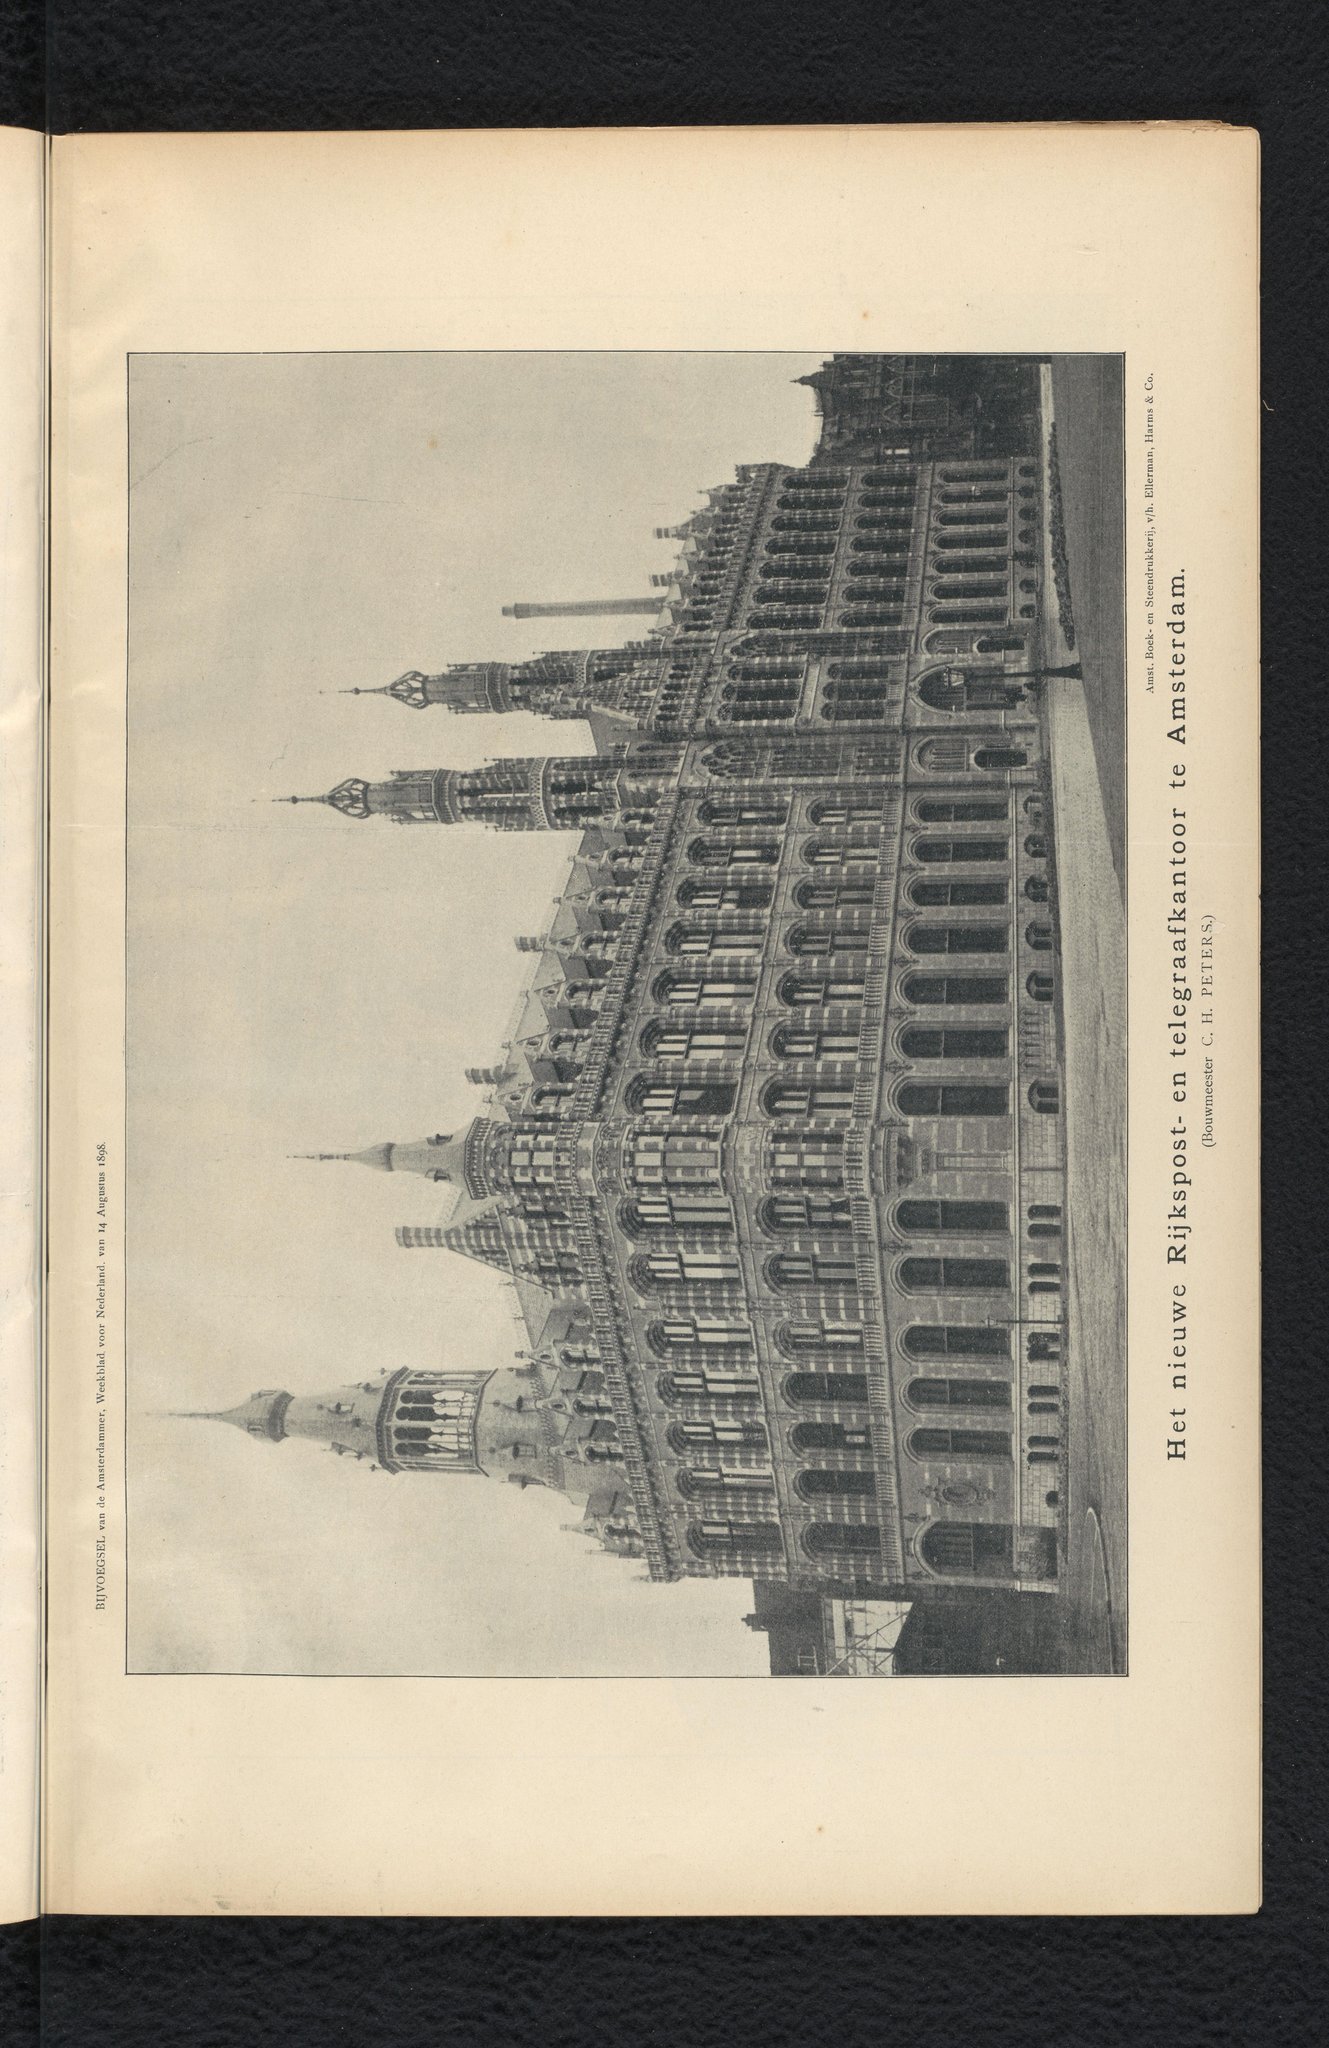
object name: photomechanical print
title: Het nieuwe Rijkspost- en telegraafkantoor te Amsterdam (bouwmeester C.H. Peters)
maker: Anonymous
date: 1898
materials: paper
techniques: autotype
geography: amsterdam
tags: post-office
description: Het (voormalige) Amsterdamse Hoofdpostkantoor, gelegen aan de Nieuwezijds Voorburgwal achter het Paleis op de Dam.